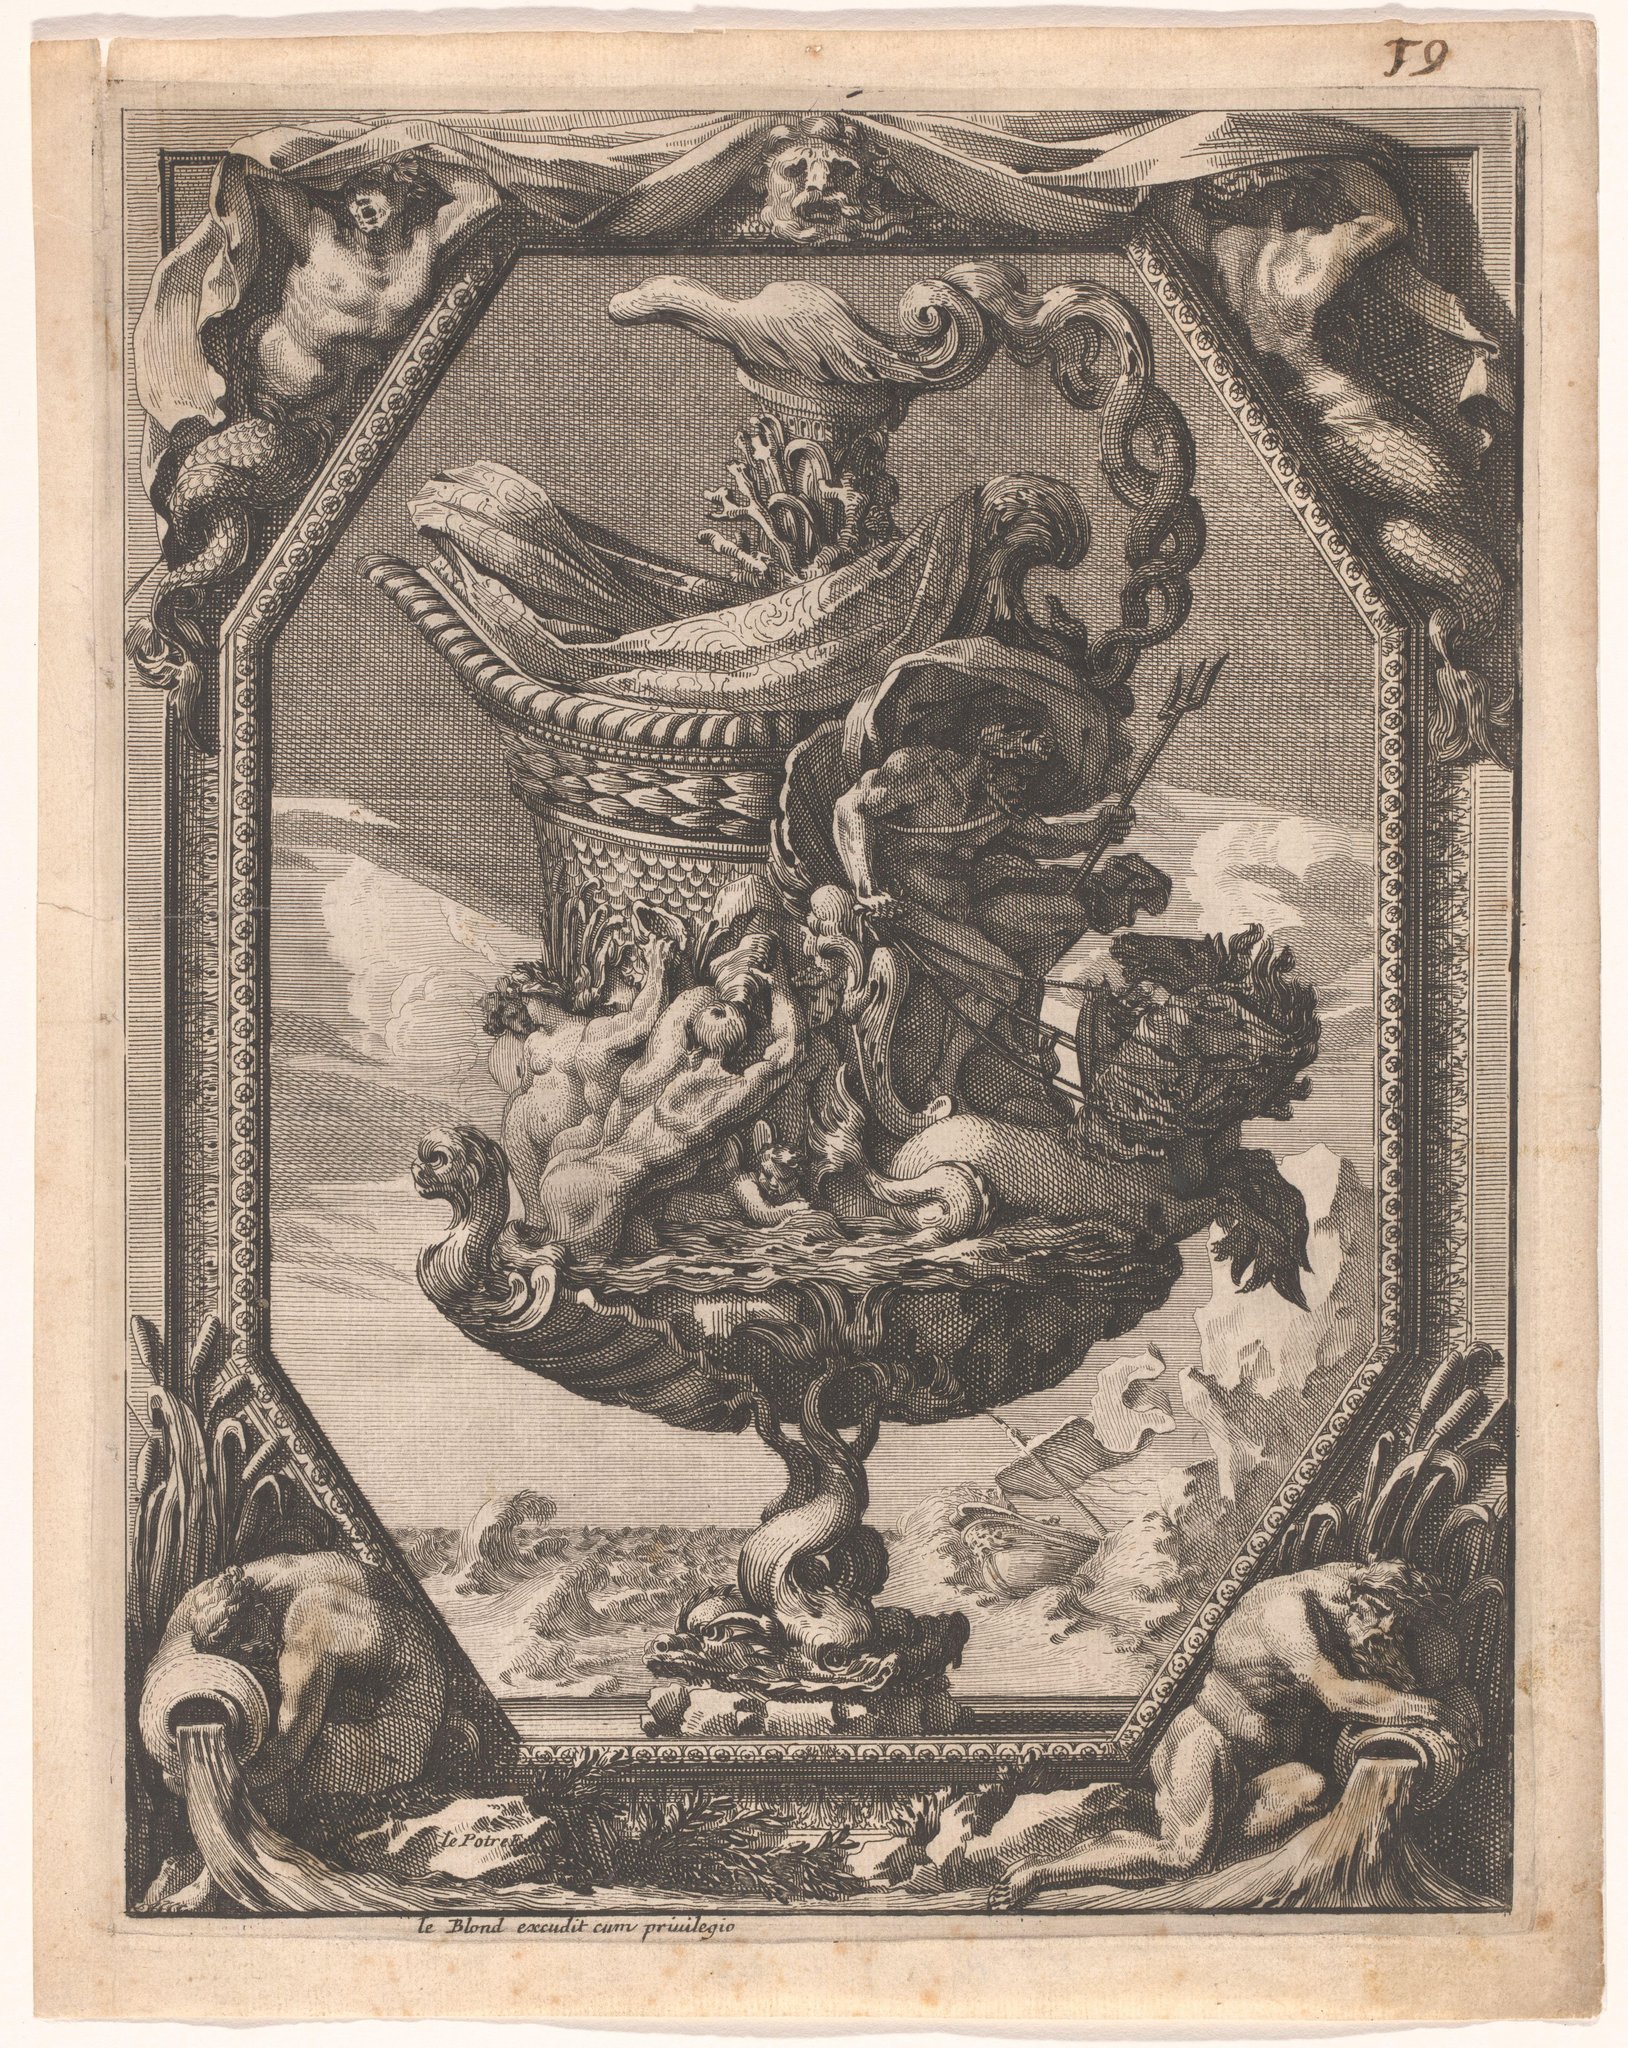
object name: print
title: Schenkkannen in ornamentele lijsten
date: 1650-1664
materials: paper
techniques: etching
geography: paris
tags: (story of) neptune (poseidon), vase ~ ornament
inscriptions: collector's mark: Lugt 2228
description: Een geornamenteerde schenkkan met Neptunus in zijn strijdwagen. De kan is gevat in een ornamentele omlijsting met meermannen en riviergoden.